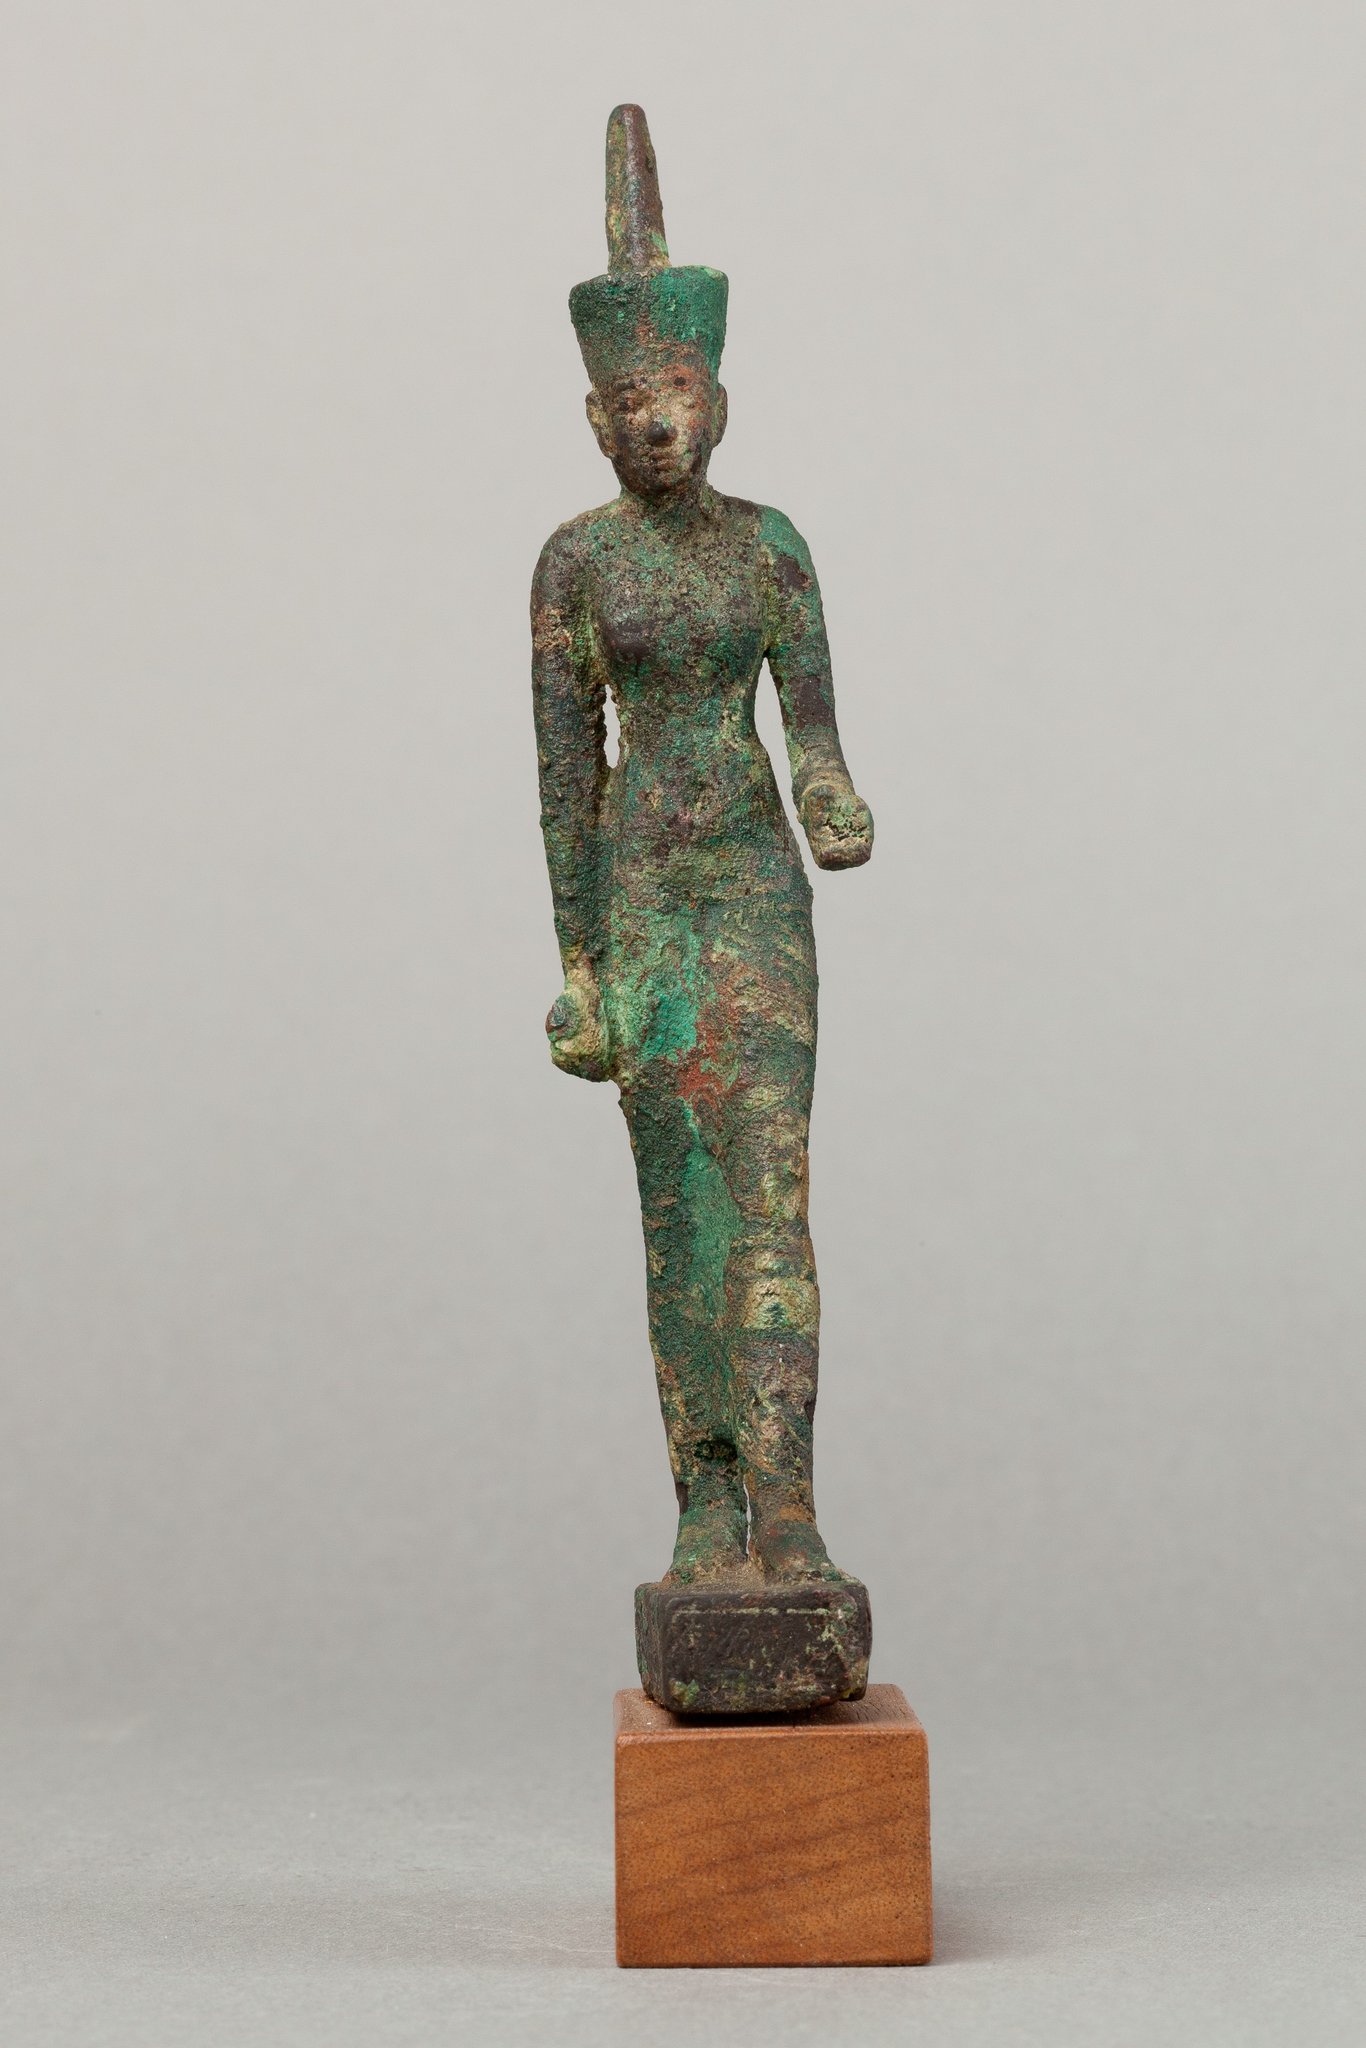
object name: statuette, neit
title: Neit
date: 664-332 BCE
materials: metal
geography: egypt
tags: goddess